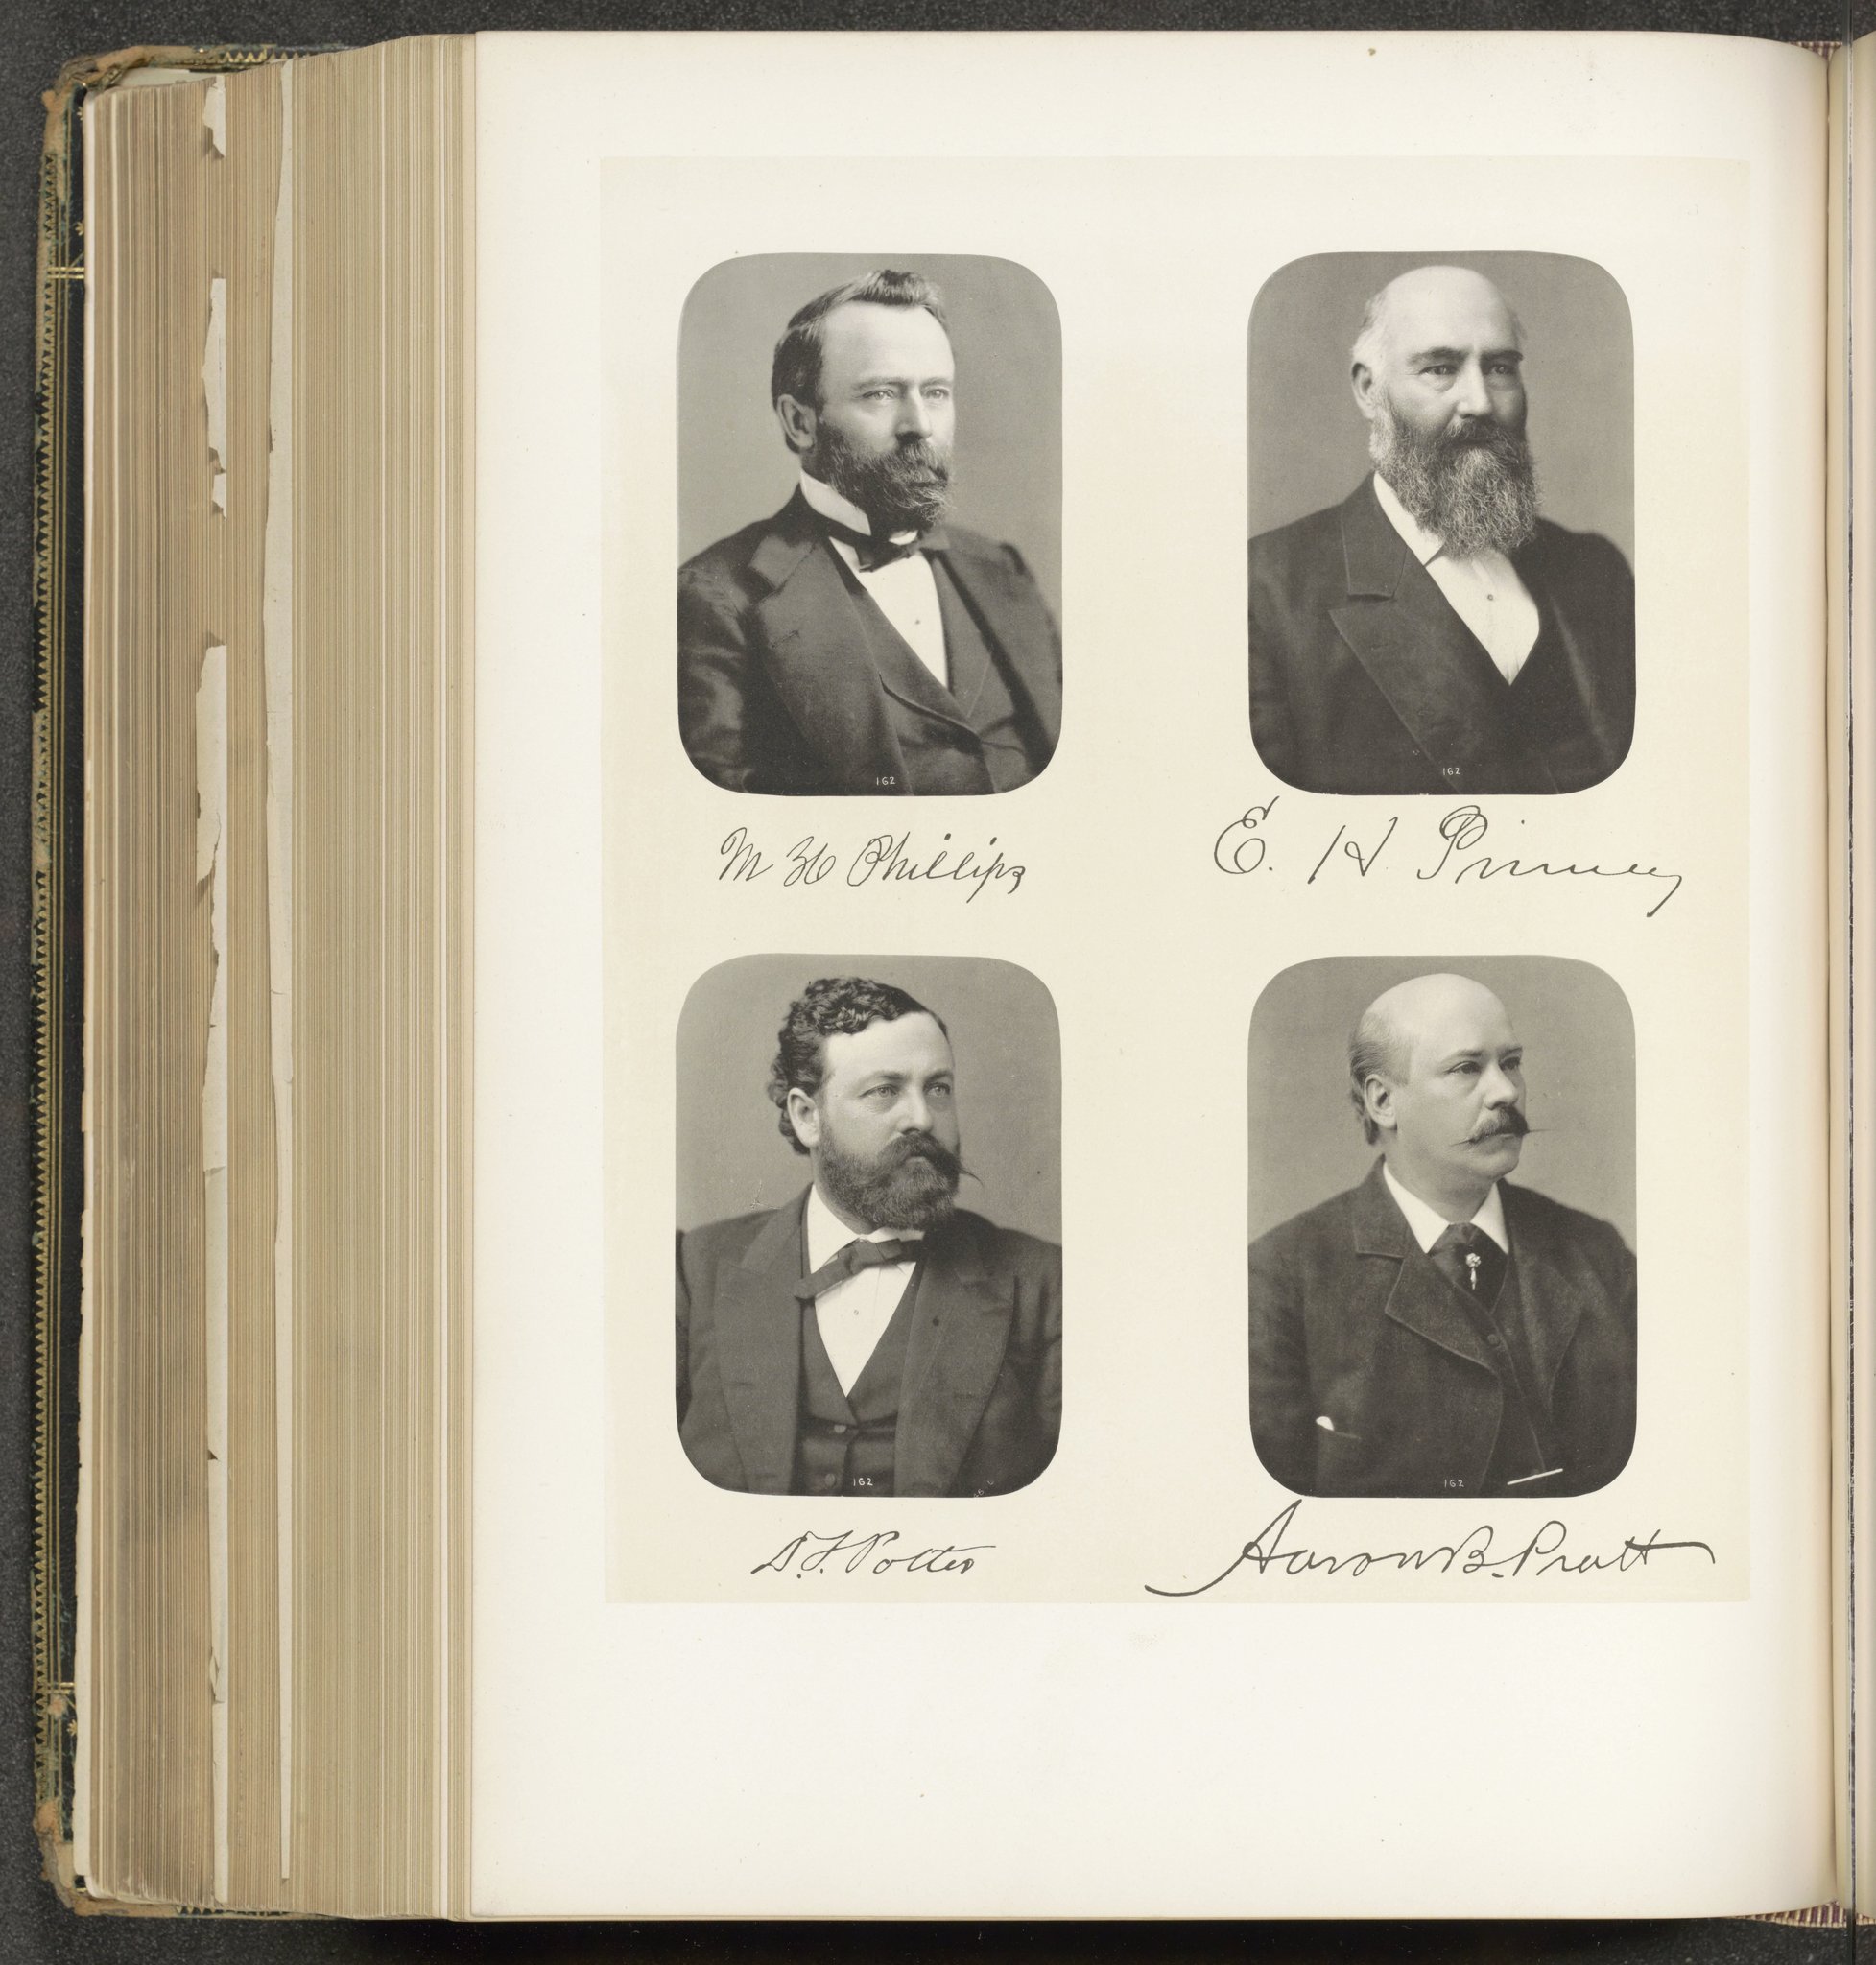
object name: photomechanical print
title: Portretten van vier leden van het Lagerhuis van de staat New York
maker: Anonymous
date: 1872-1882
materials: paper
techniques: photograph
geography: united states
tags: historical persons (portraits and scenes from the life) (+ head (and shoulders) (portrait))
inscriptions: annotation, number: ‘162’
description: Linksboven Marcus H. Phillips, rechtsboven Edward H. Pinney, linksonder Delcour S. Potter, rechtsonder Aaron B. Pratt.